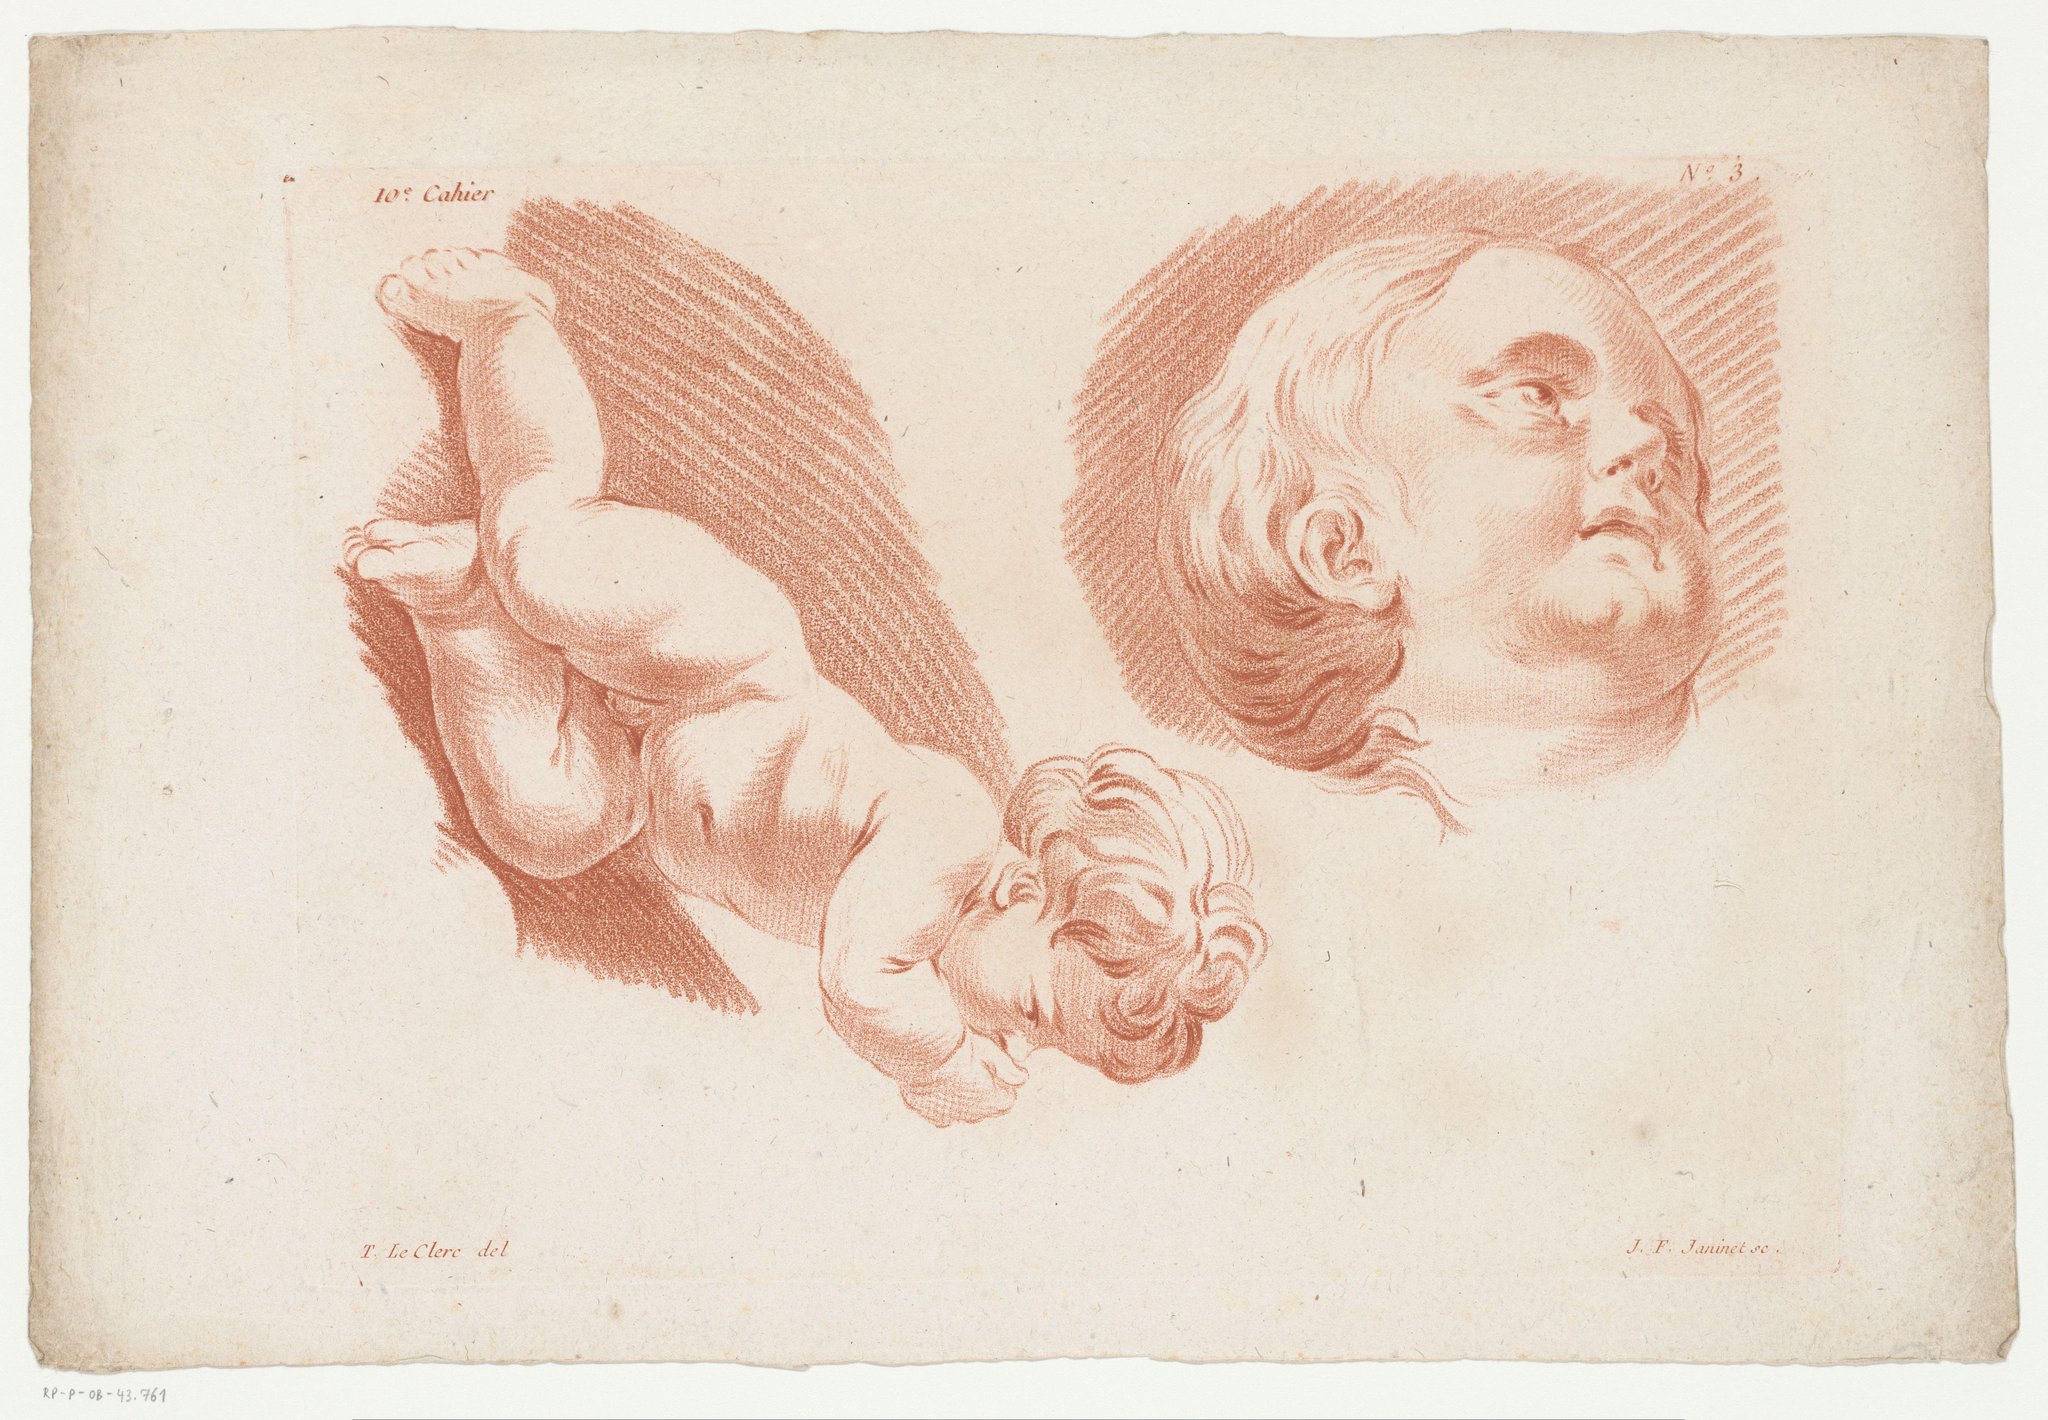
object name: print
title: Composities met menselijke lichaamsdelen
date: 1773-1777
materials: paper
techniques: printmaking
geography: paris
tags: child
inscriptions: collector's mark: Lugt 2228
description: Deze prent maakt deel uit van een album dat uit minstens elf delen bestaat. Dit is het derde blad van het tiende album. Waarschijnlijk dienden deze albums als voorbeeld voor tekenaars, schilders en graveurs.